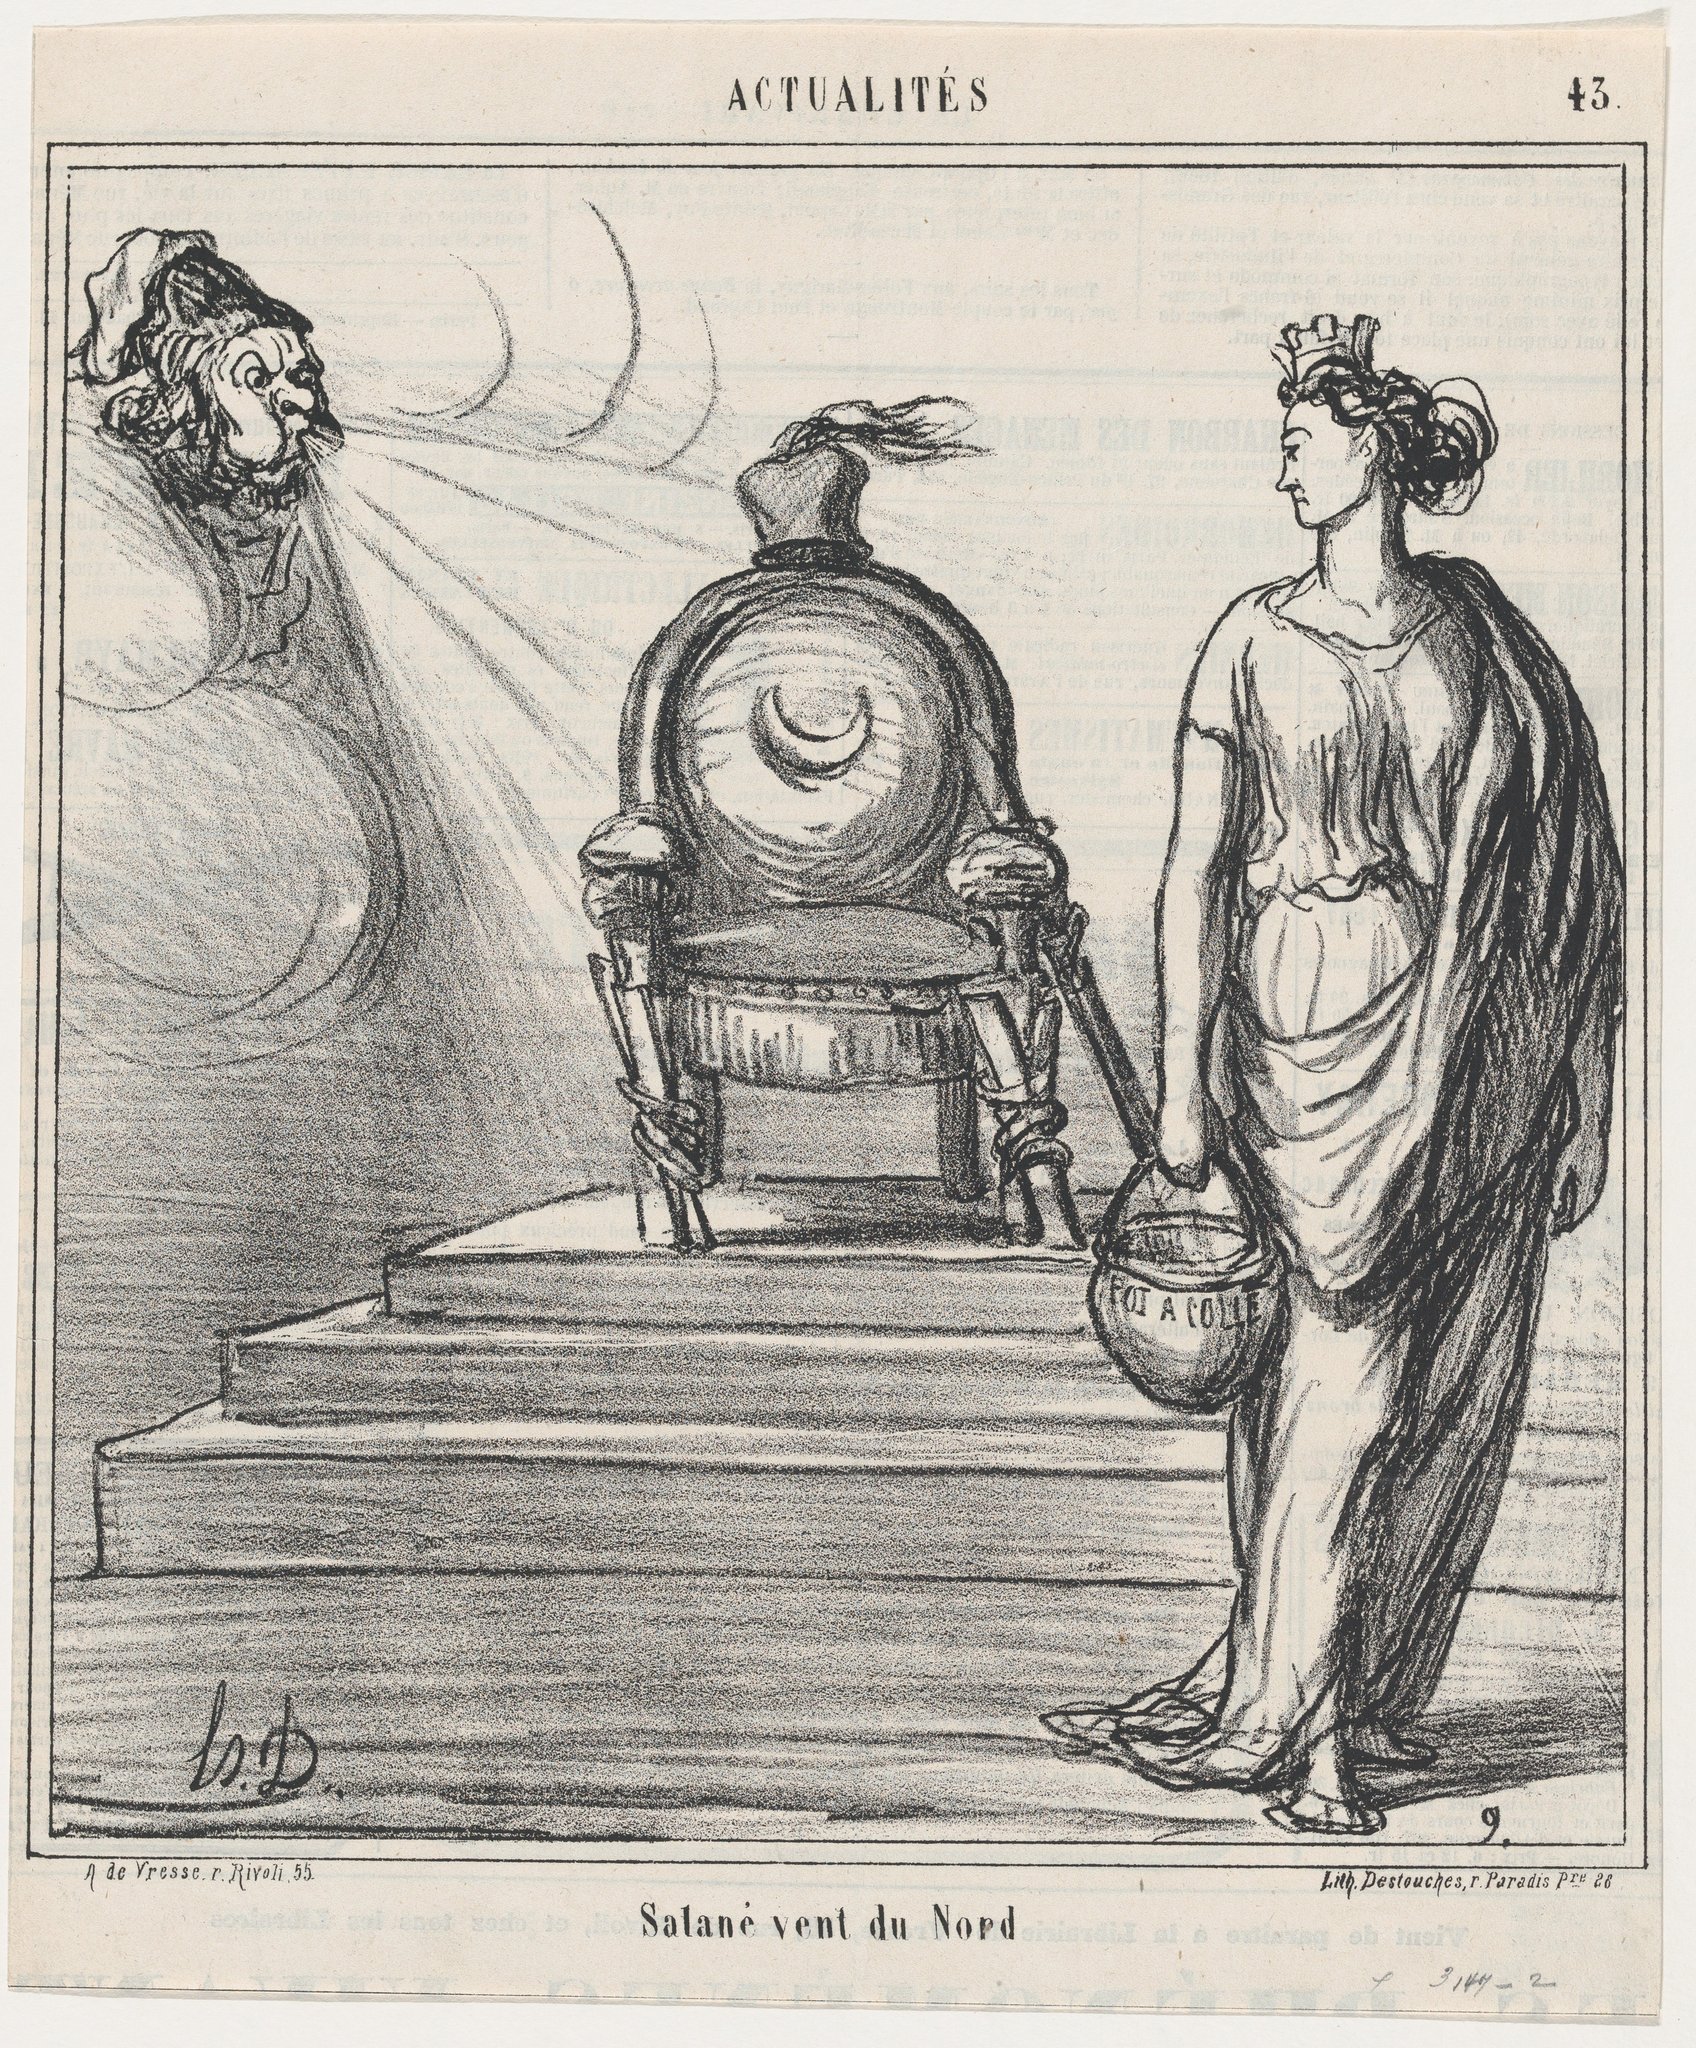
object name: print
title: Devilish north wind!, from 'News of the day,' published in "Le Charivari"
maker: honoré daumier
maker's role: artist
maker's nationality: french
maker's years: 1808-1879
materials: paper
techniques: lithograph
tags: women,devil